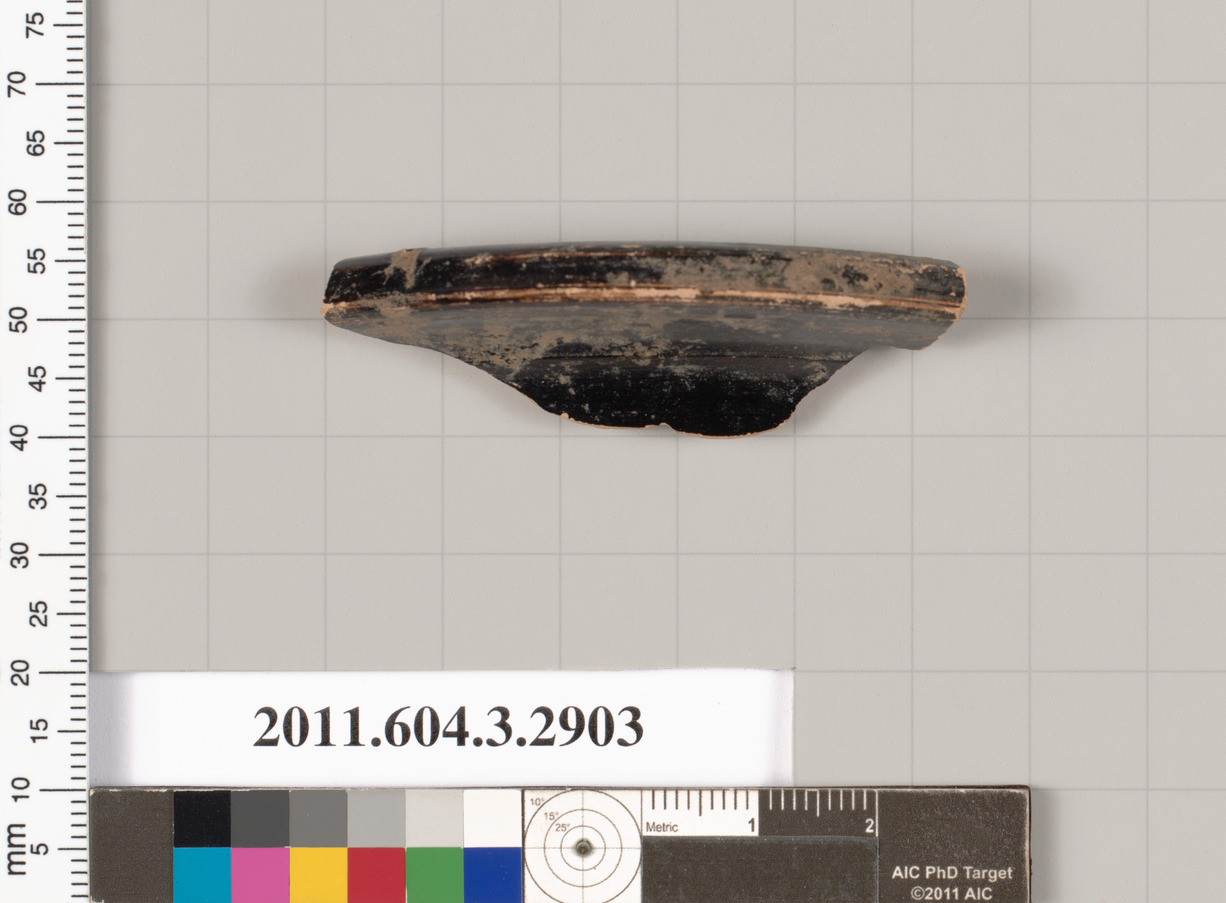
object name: oinochoe fragment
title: Terracotta fragment of an oinochoe (jug)?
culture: greek, attic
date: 500-401 BCE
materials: terracotta